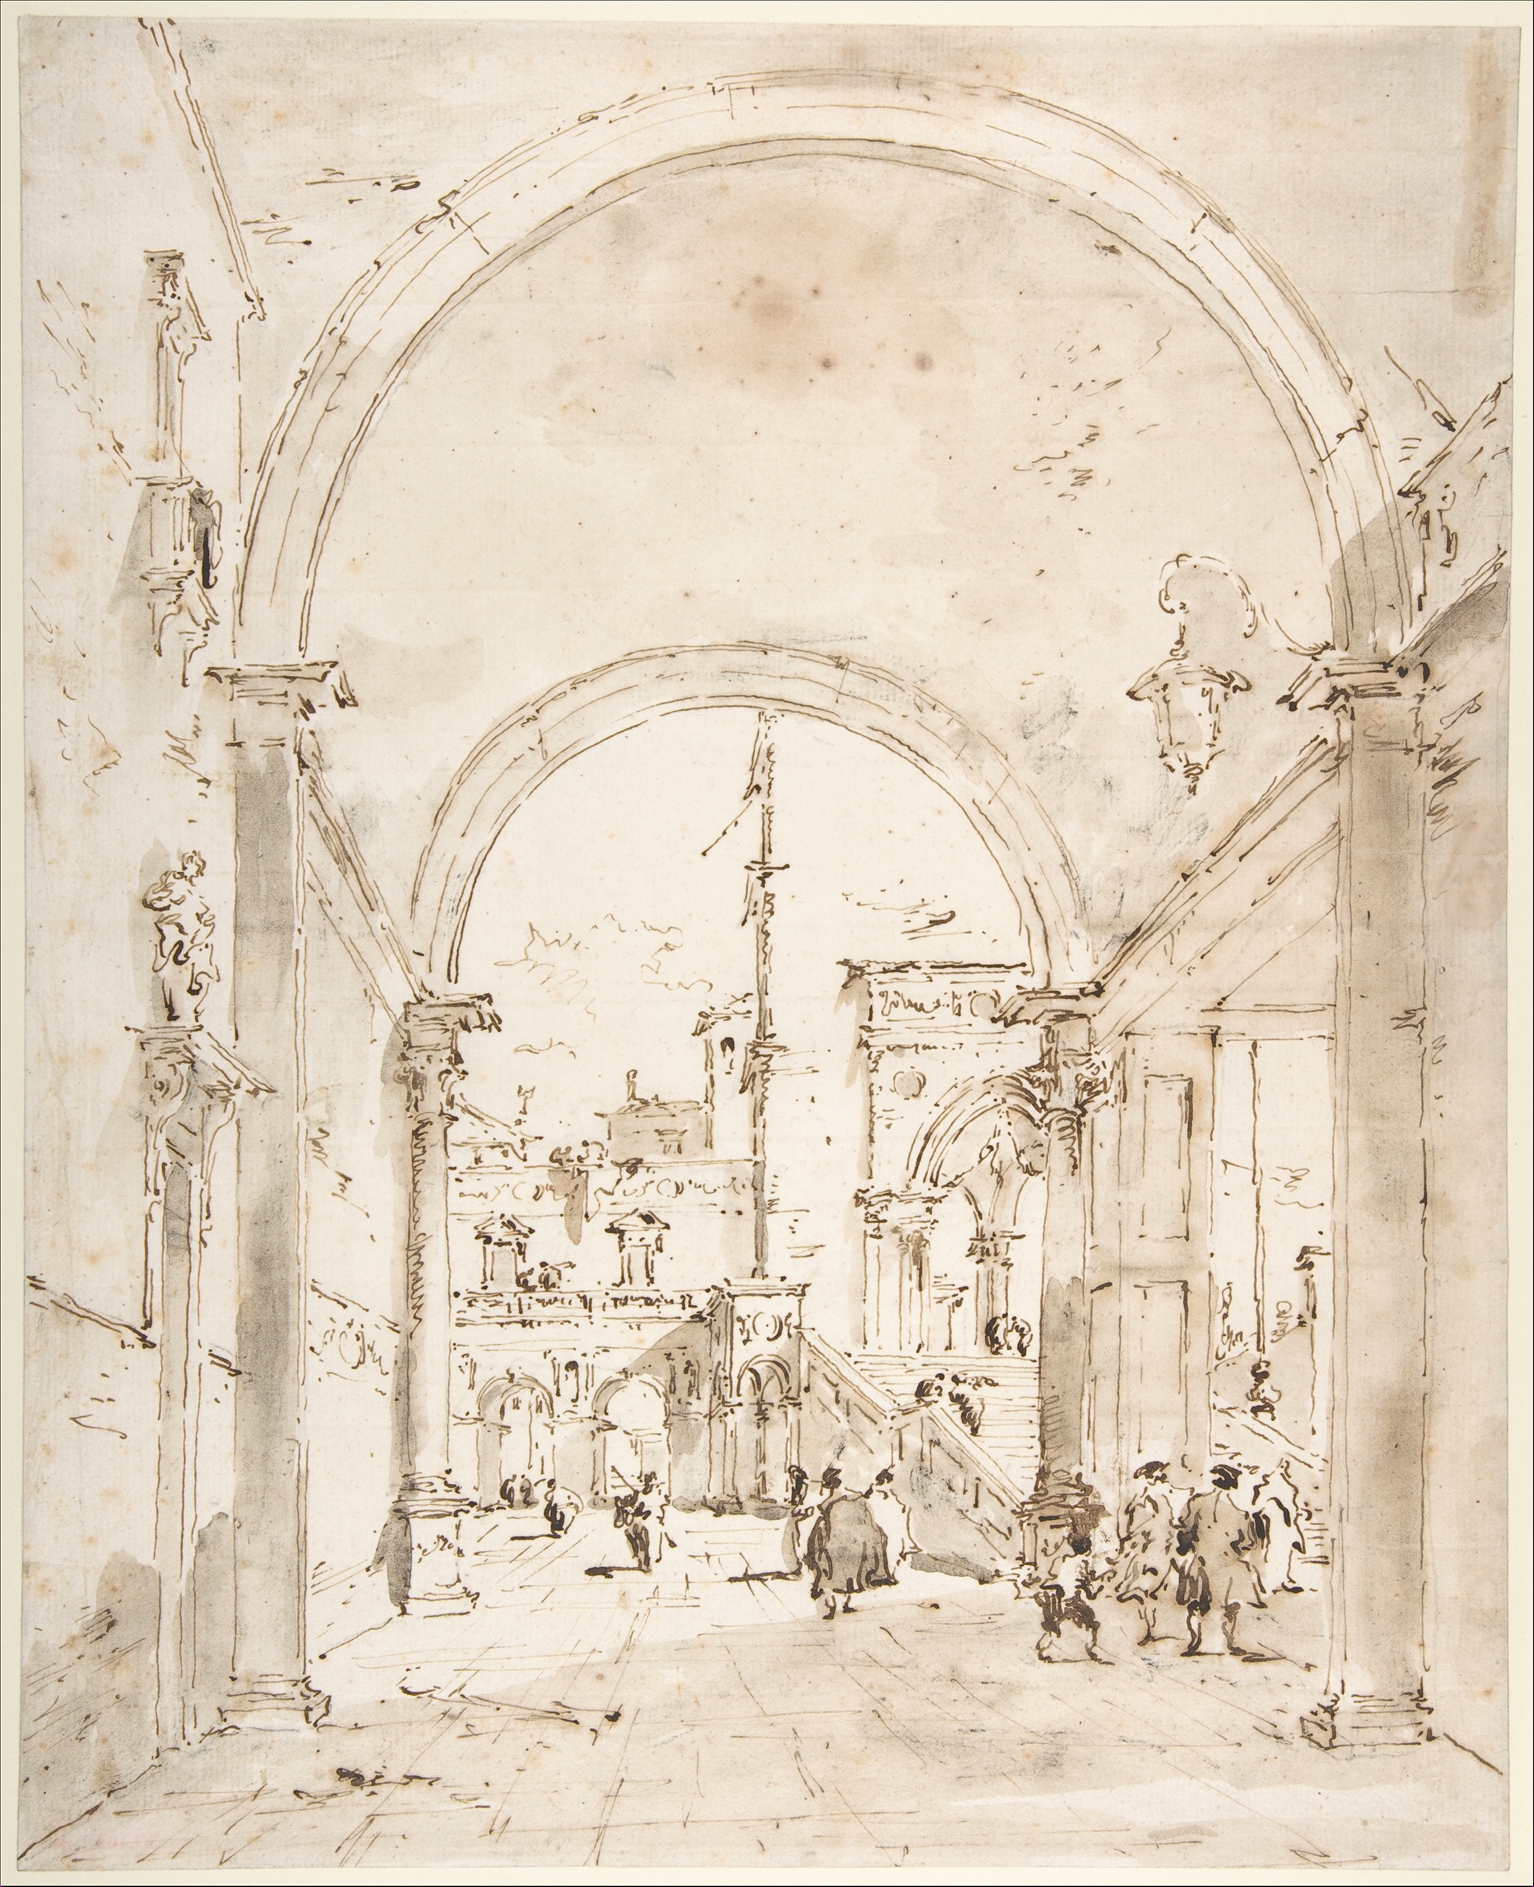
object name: drawing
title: Architectural Capriccio: Grand Staircase Seen through an Archway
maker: francesco guardi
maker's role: artist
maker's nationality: italian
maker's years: 1712-1793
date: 1712-1793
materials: chalk, ink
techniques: brush, pen, wash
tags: arches,stairs